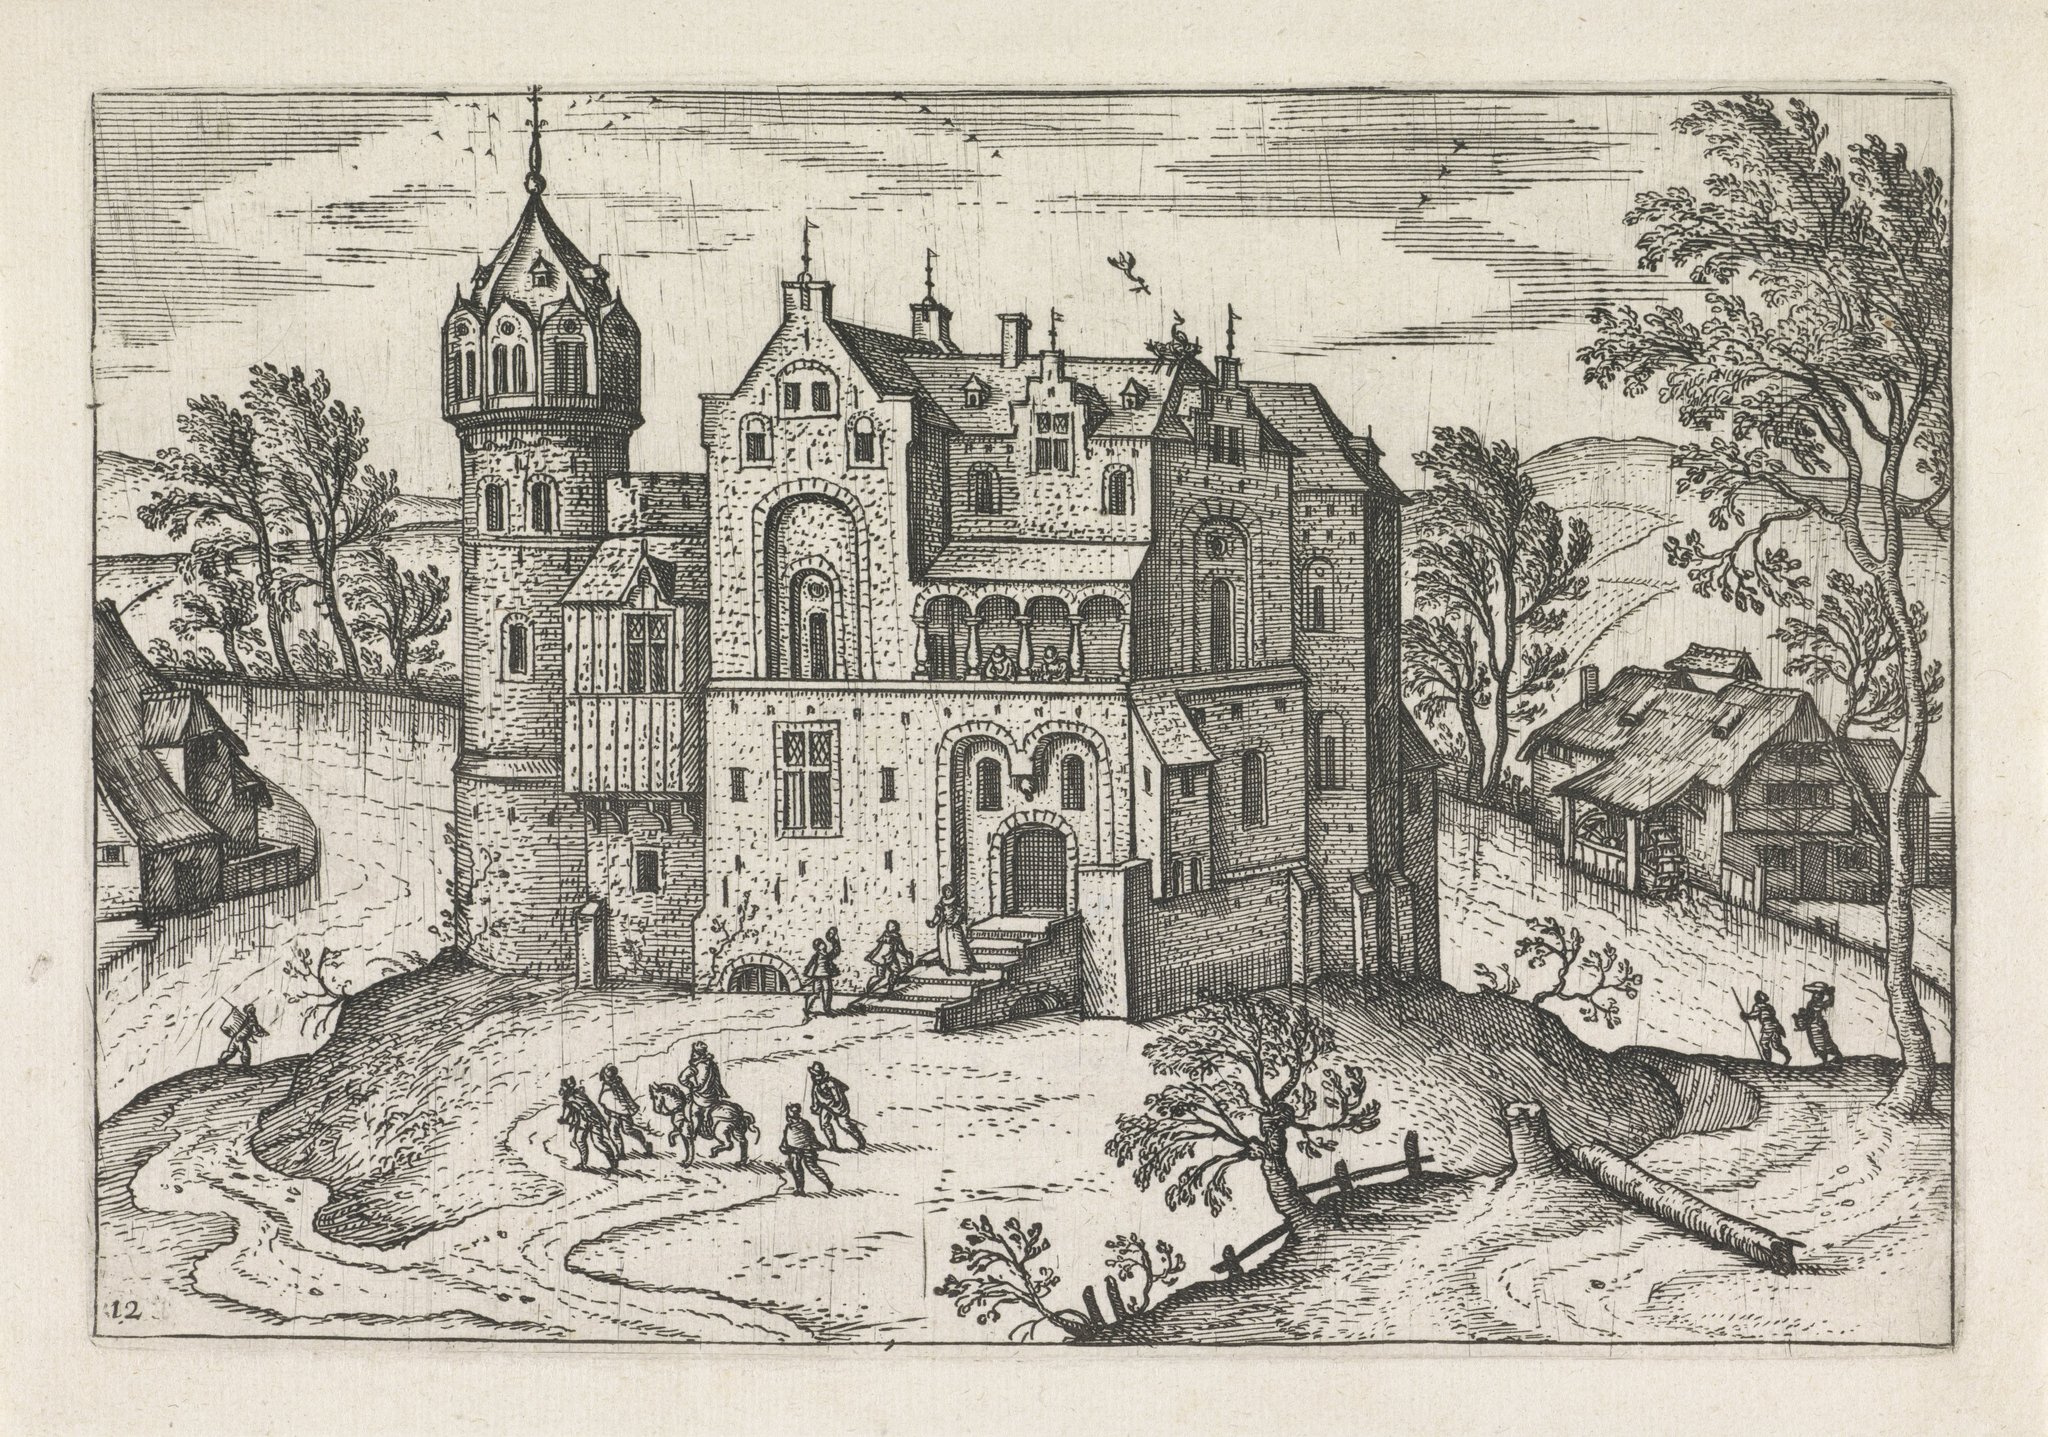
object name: print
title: Kasteel aan een rivier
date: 1601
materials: paper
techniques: etching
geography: antwerp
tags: castle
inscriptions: collector's mark: Lugt 2228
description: Deze prent is door uitgever Philips Galle toegevoegd aan de serie Kleine Landschappen, die door de gebroeders van Doetecum is gegraveerd naar ontwerp van de Meester van de Kleine Landschappen.